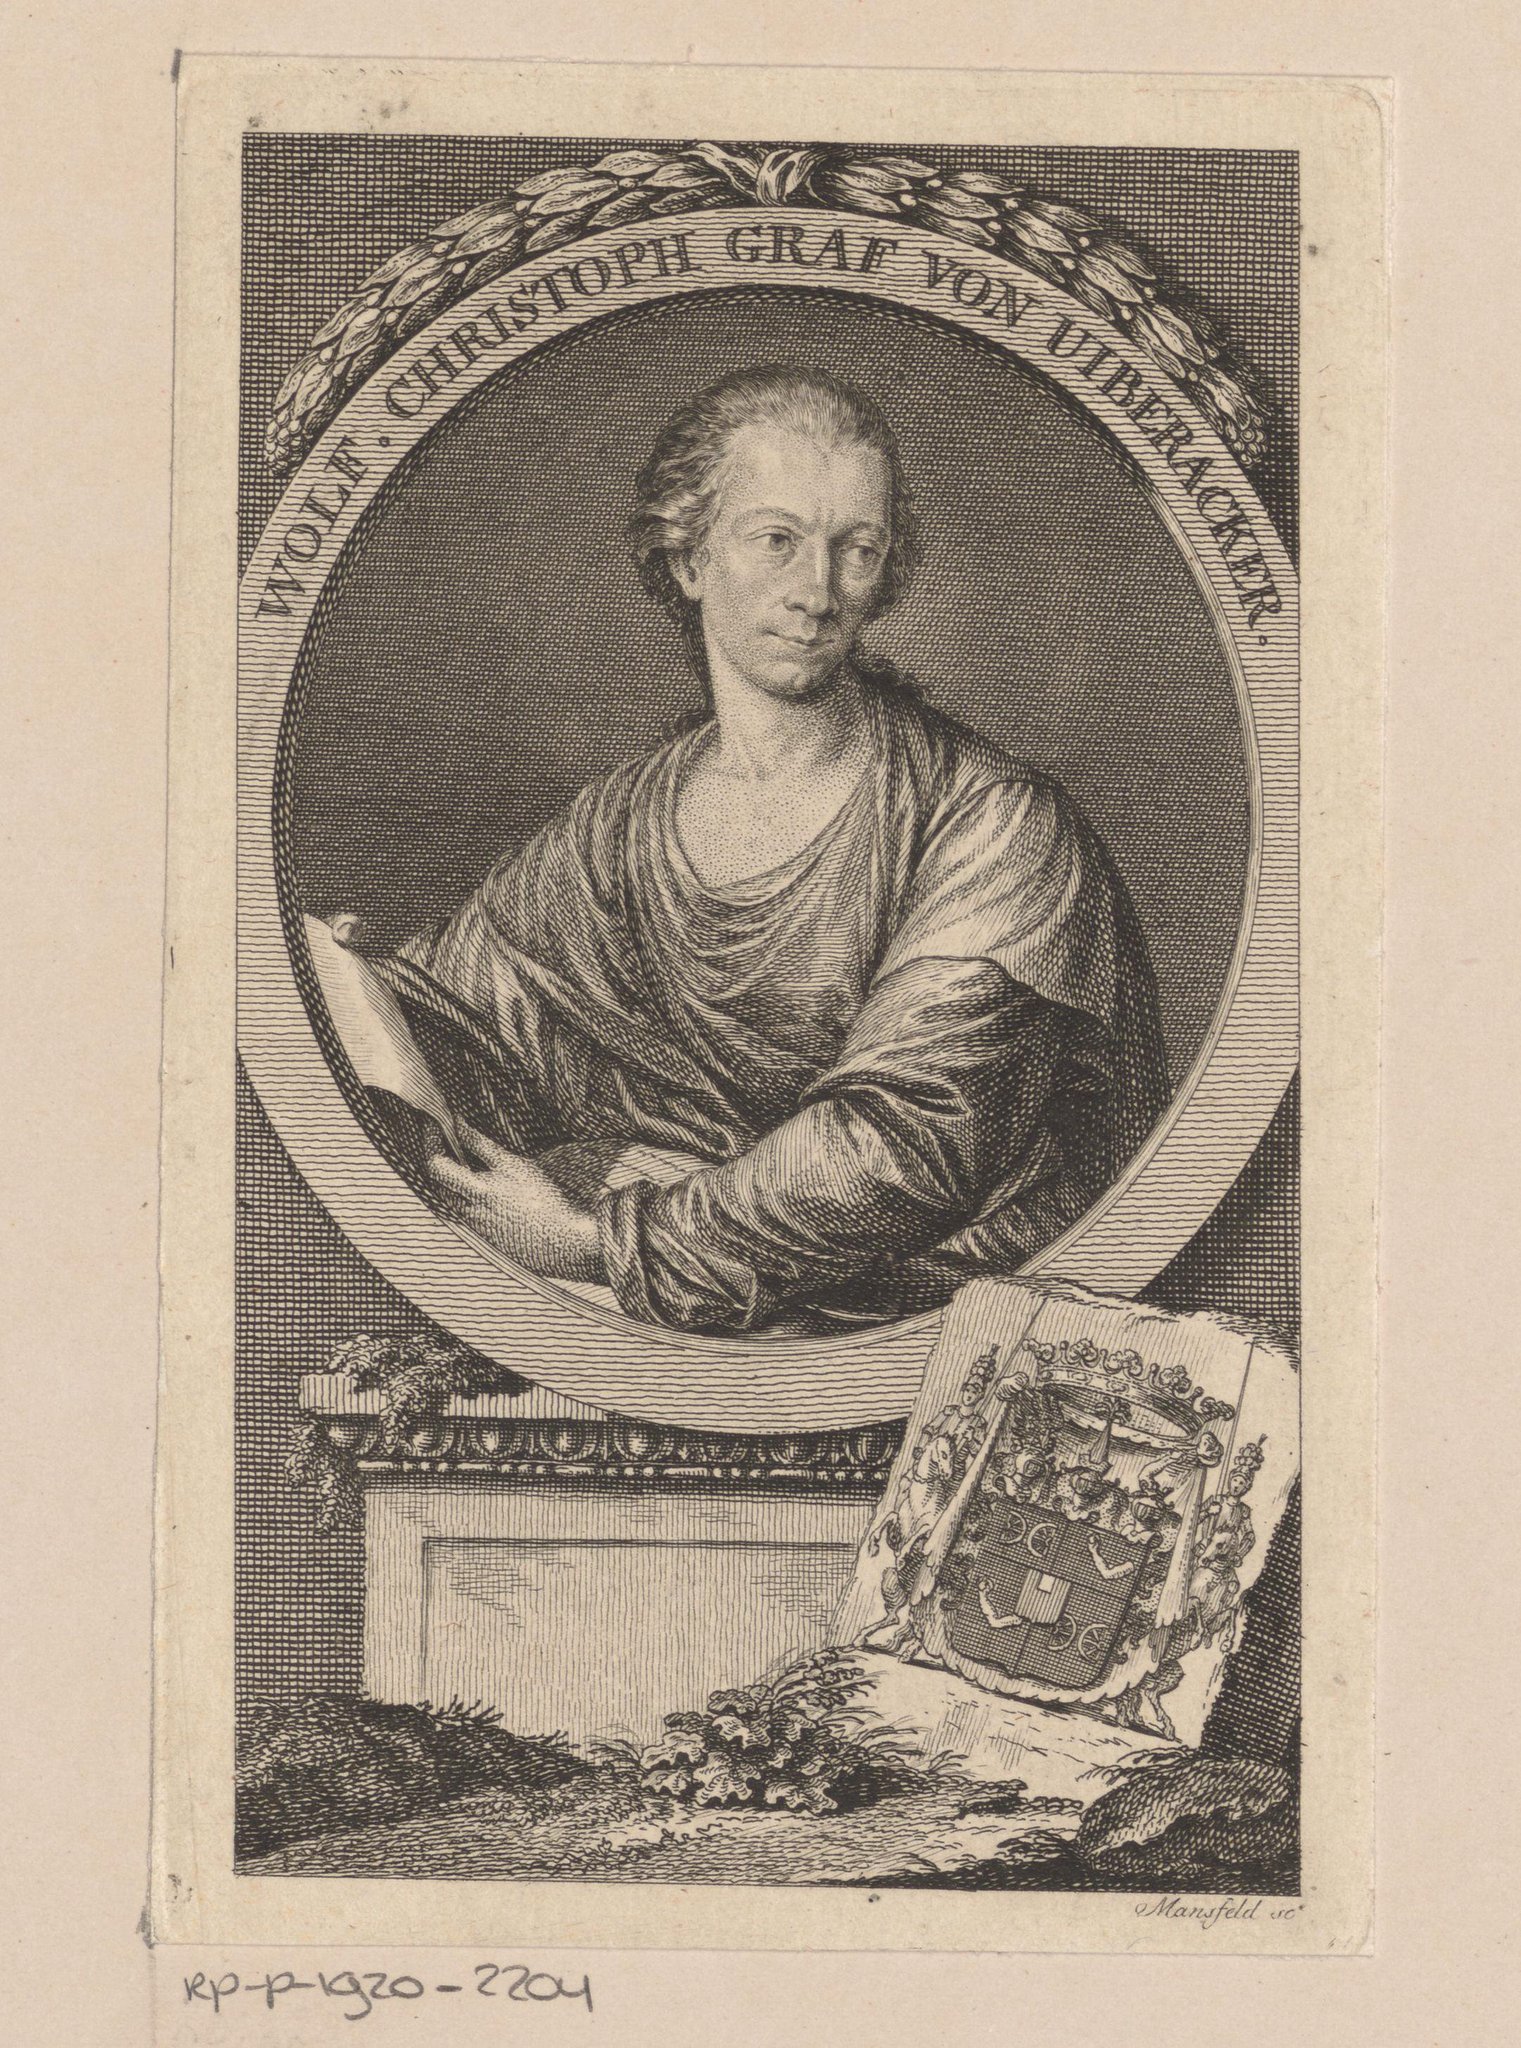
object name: print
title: Portret van Wolfgang Christoph von Uiberacker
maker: johann ernst mansfeld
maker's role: print maker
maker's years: 1739-1796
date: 1765-1796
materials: paper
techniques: engraving, etching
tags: historical persons, armorial bearing, heraldry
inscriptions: collector's mark: Lugt 2228